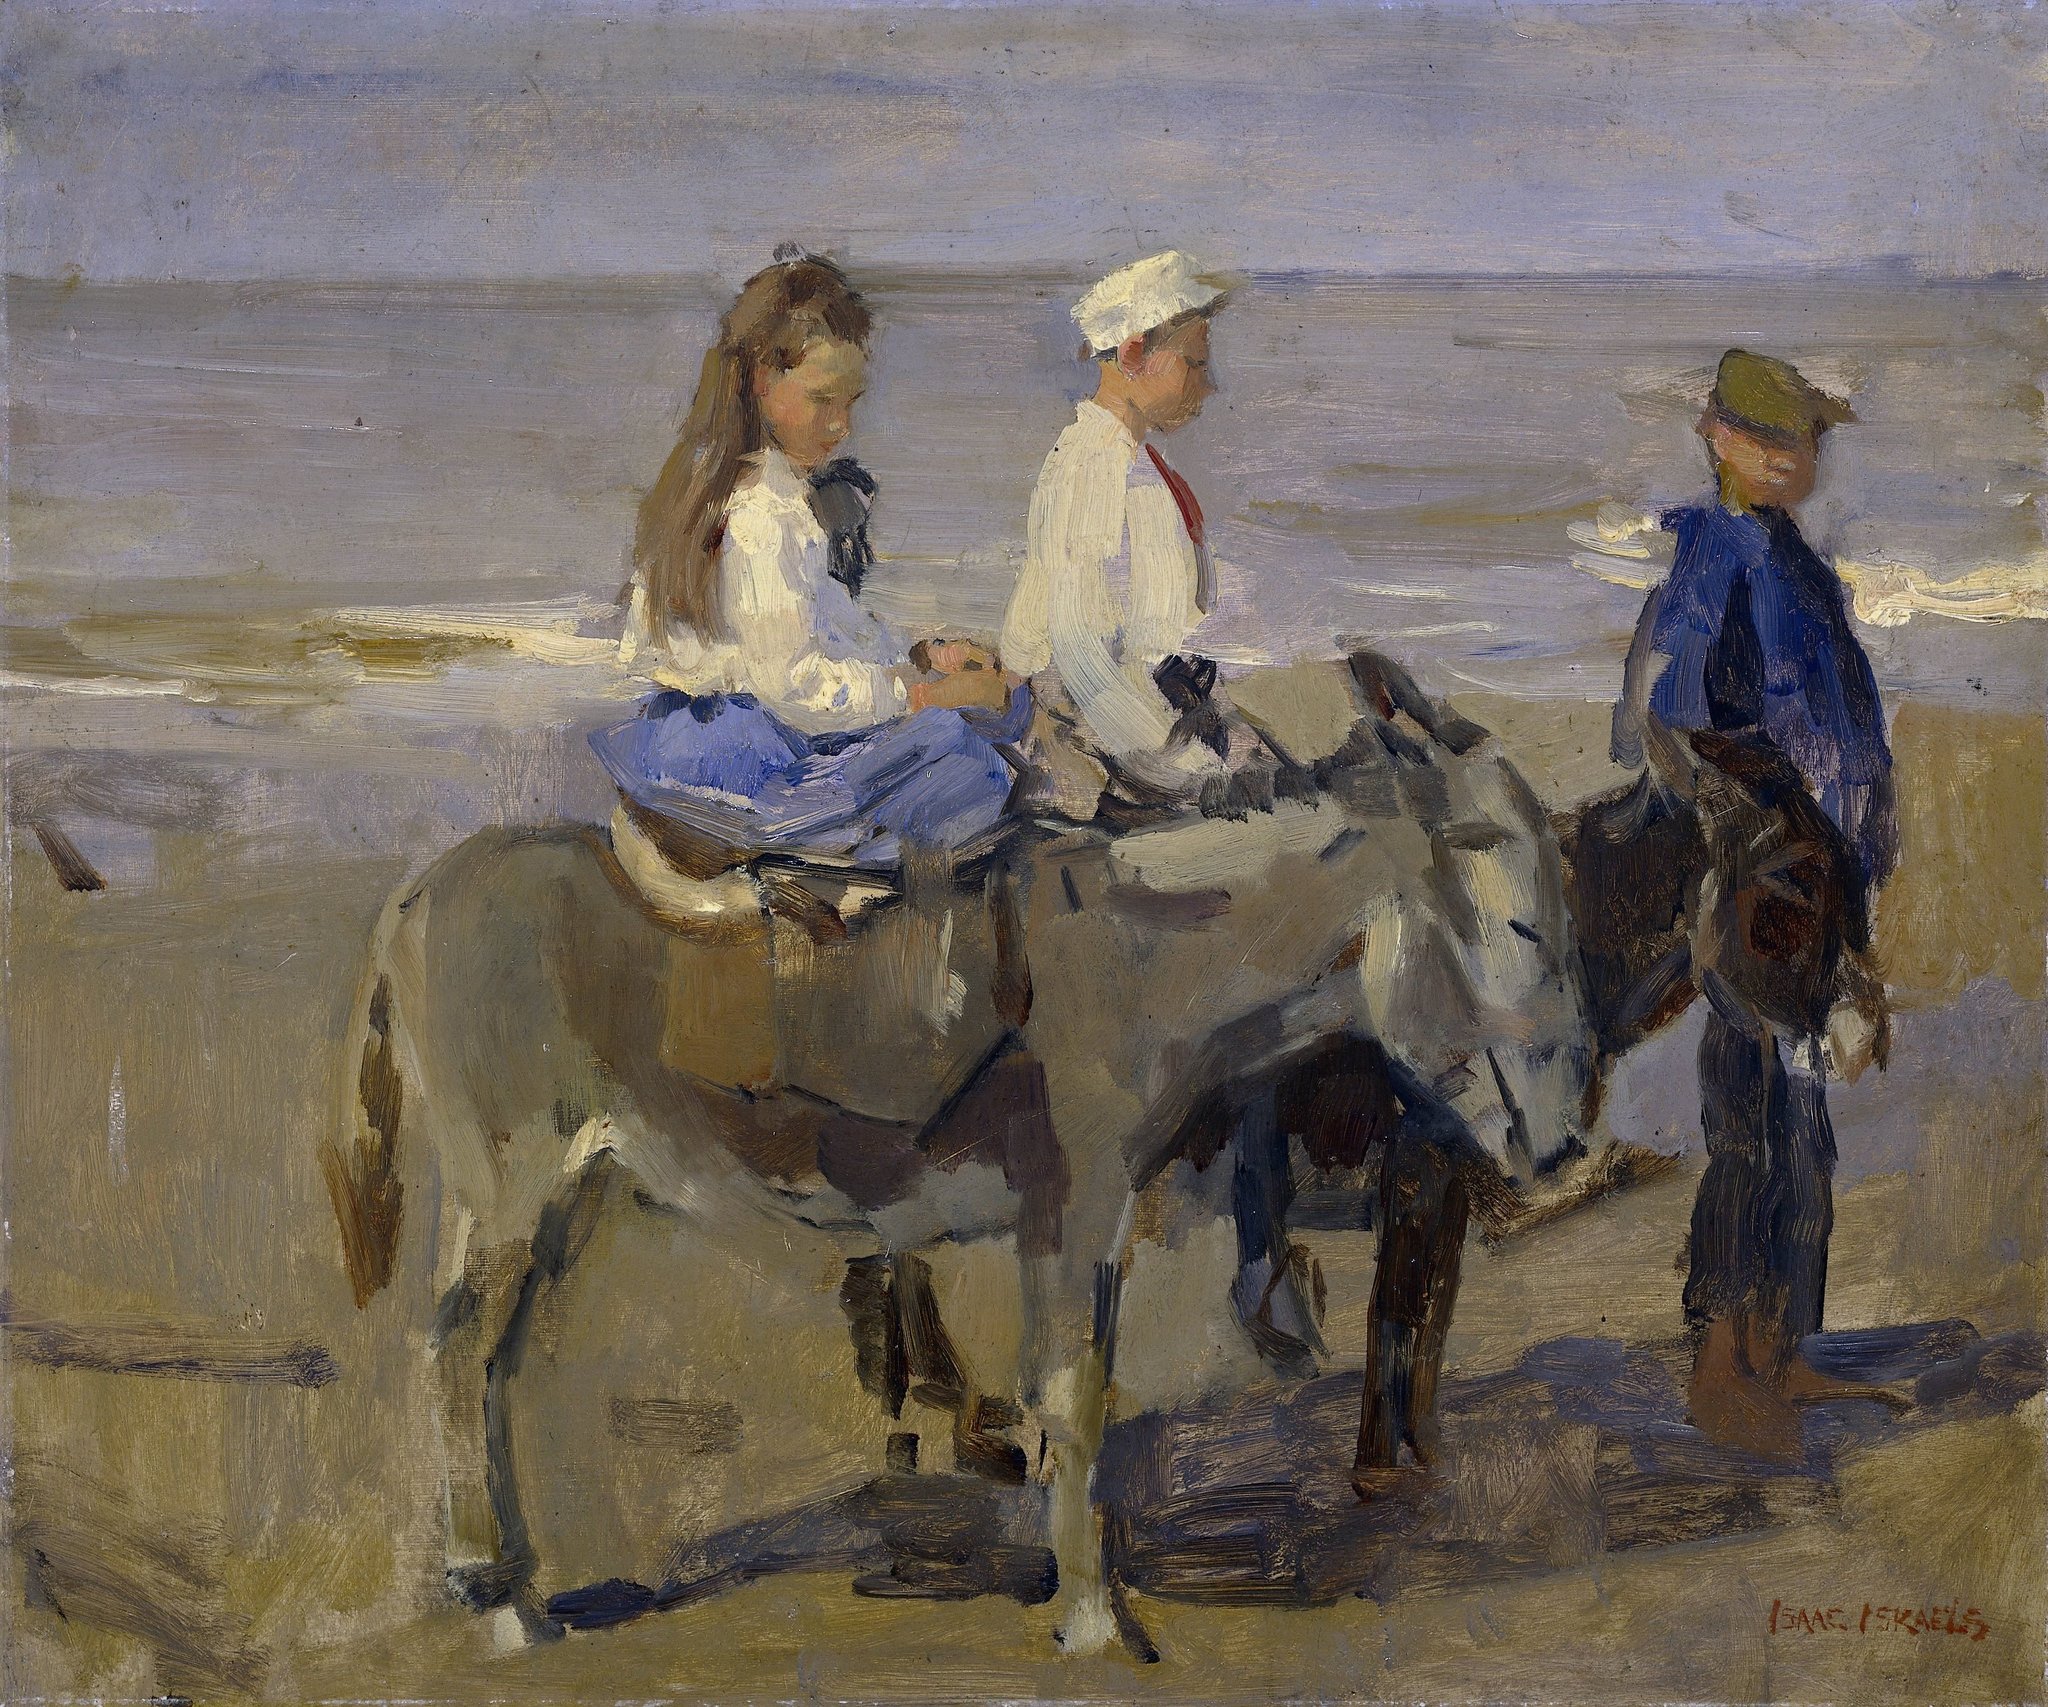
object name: painting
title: Boy and Girl on Donkeys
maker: isaac israels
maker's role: draughtsman, painter, print maker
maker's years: 1865-1934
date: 1896-1901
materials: cardboard, oil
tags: donkey-riding (on the beach)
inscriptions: signature: ‘Isaac Israels’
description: Een jongen en een meisje maken op het strand een ritje op ezeltjes. Rechts een staande jongen die de ezels leidt.